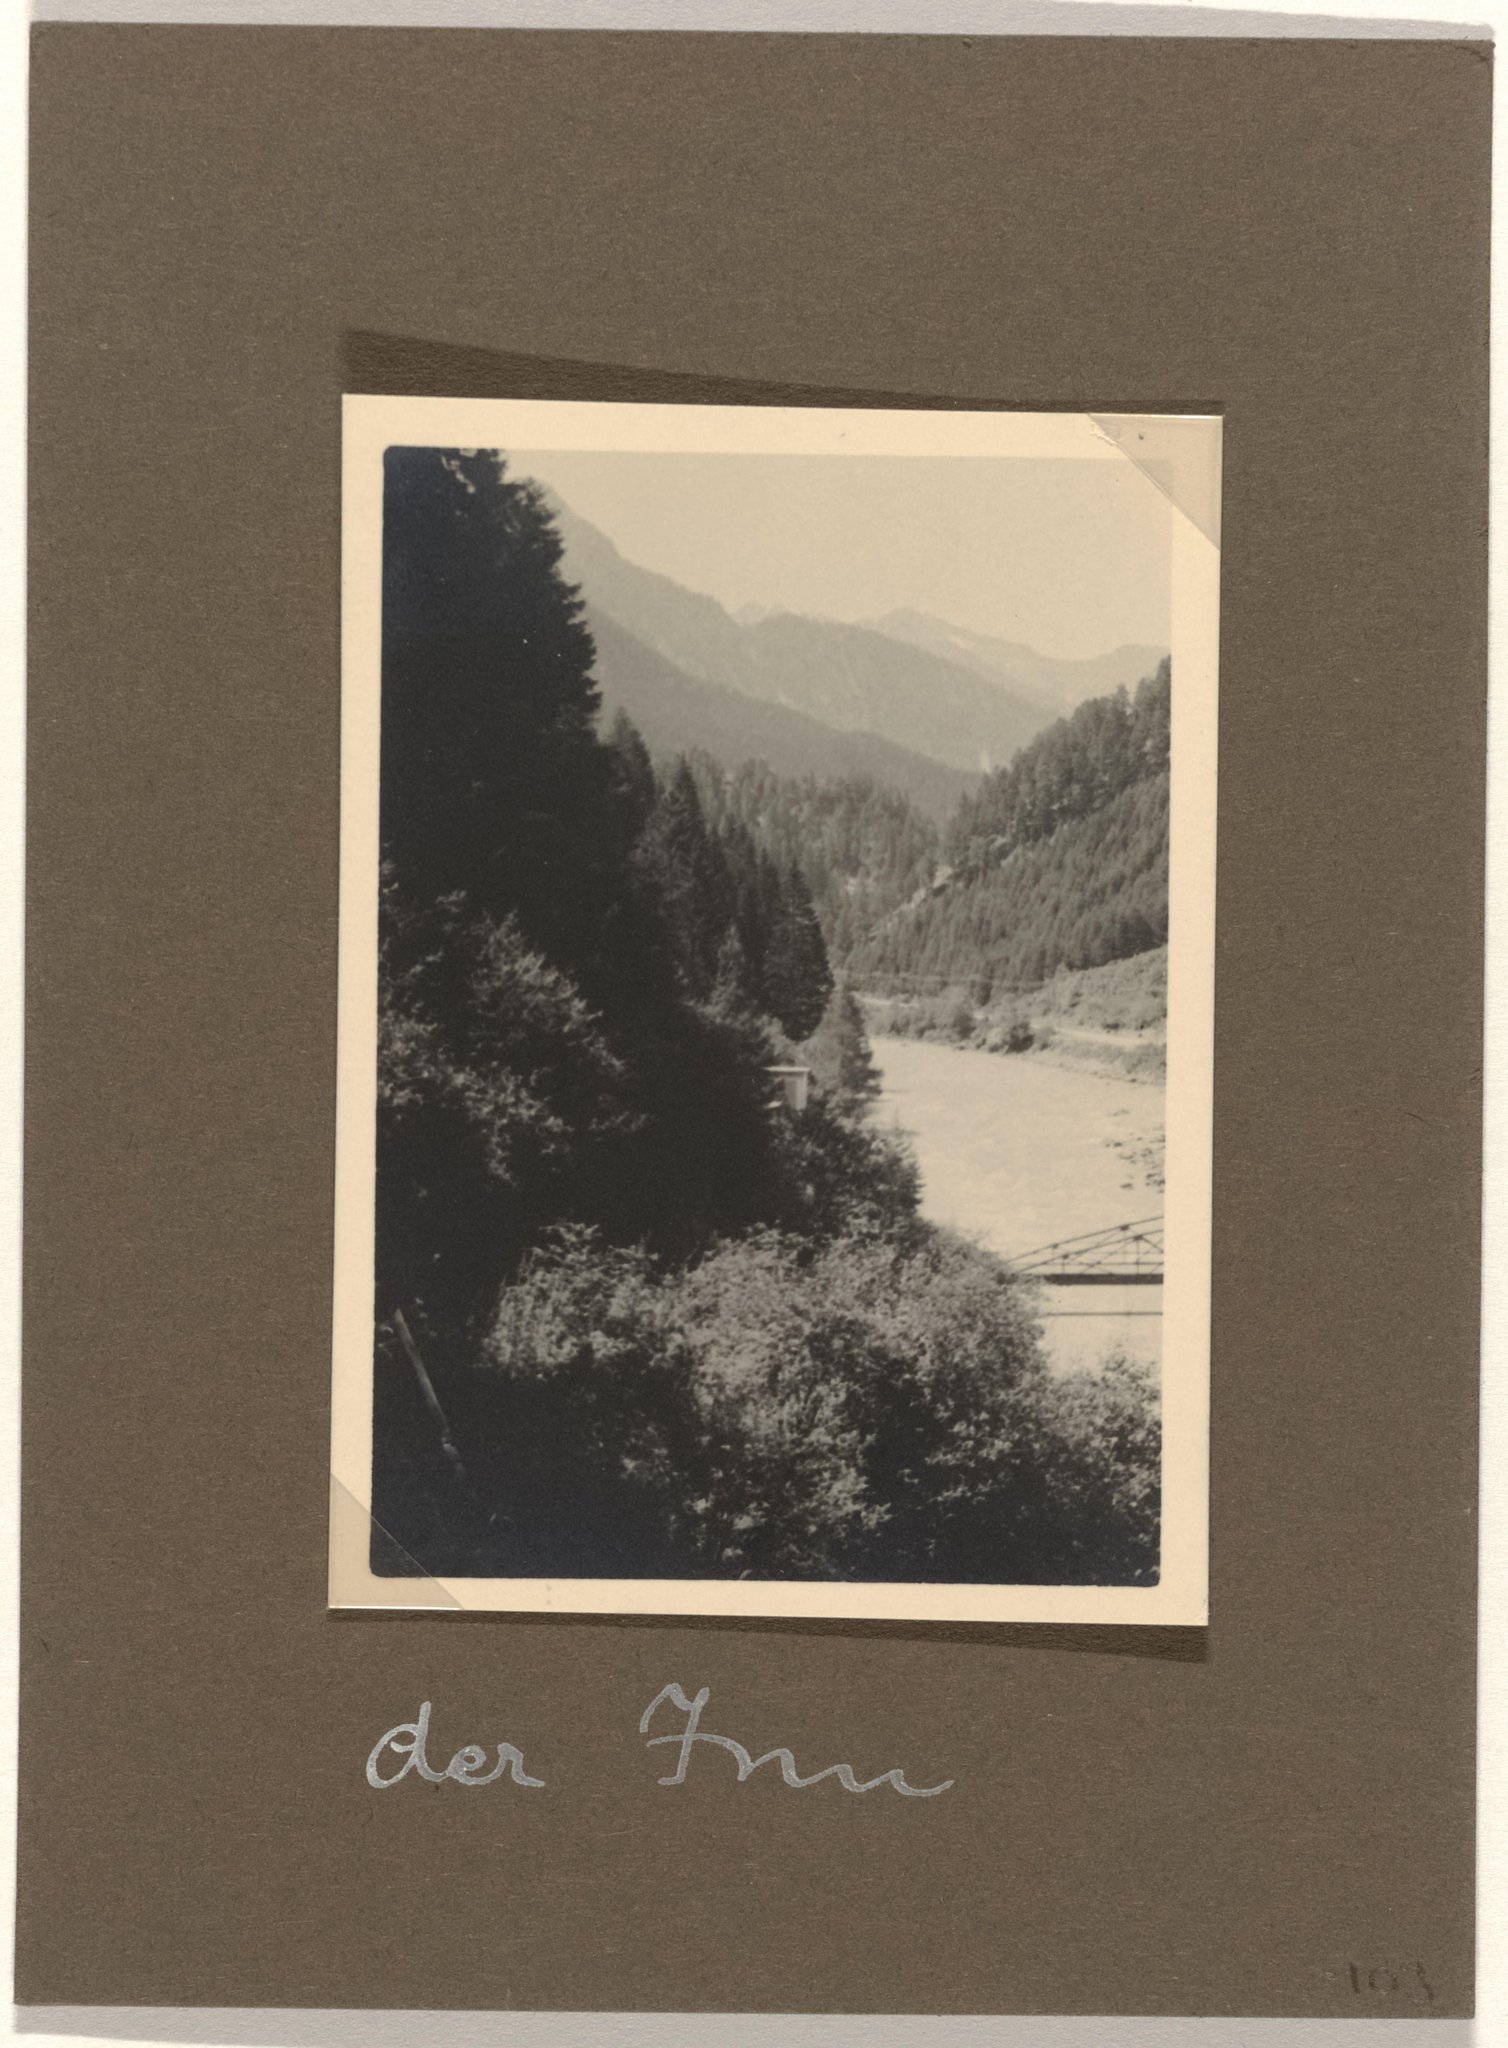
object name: photograph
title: Rivier de Inn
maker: Anonymous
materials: photographic support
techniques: gelatin silver print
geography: austria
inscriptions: inscription: ‘der Inn’